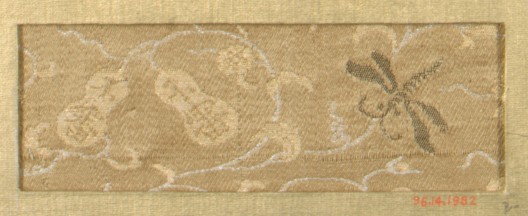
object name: piece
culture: japanese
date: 1701-1900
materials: silk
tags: insects,gourds